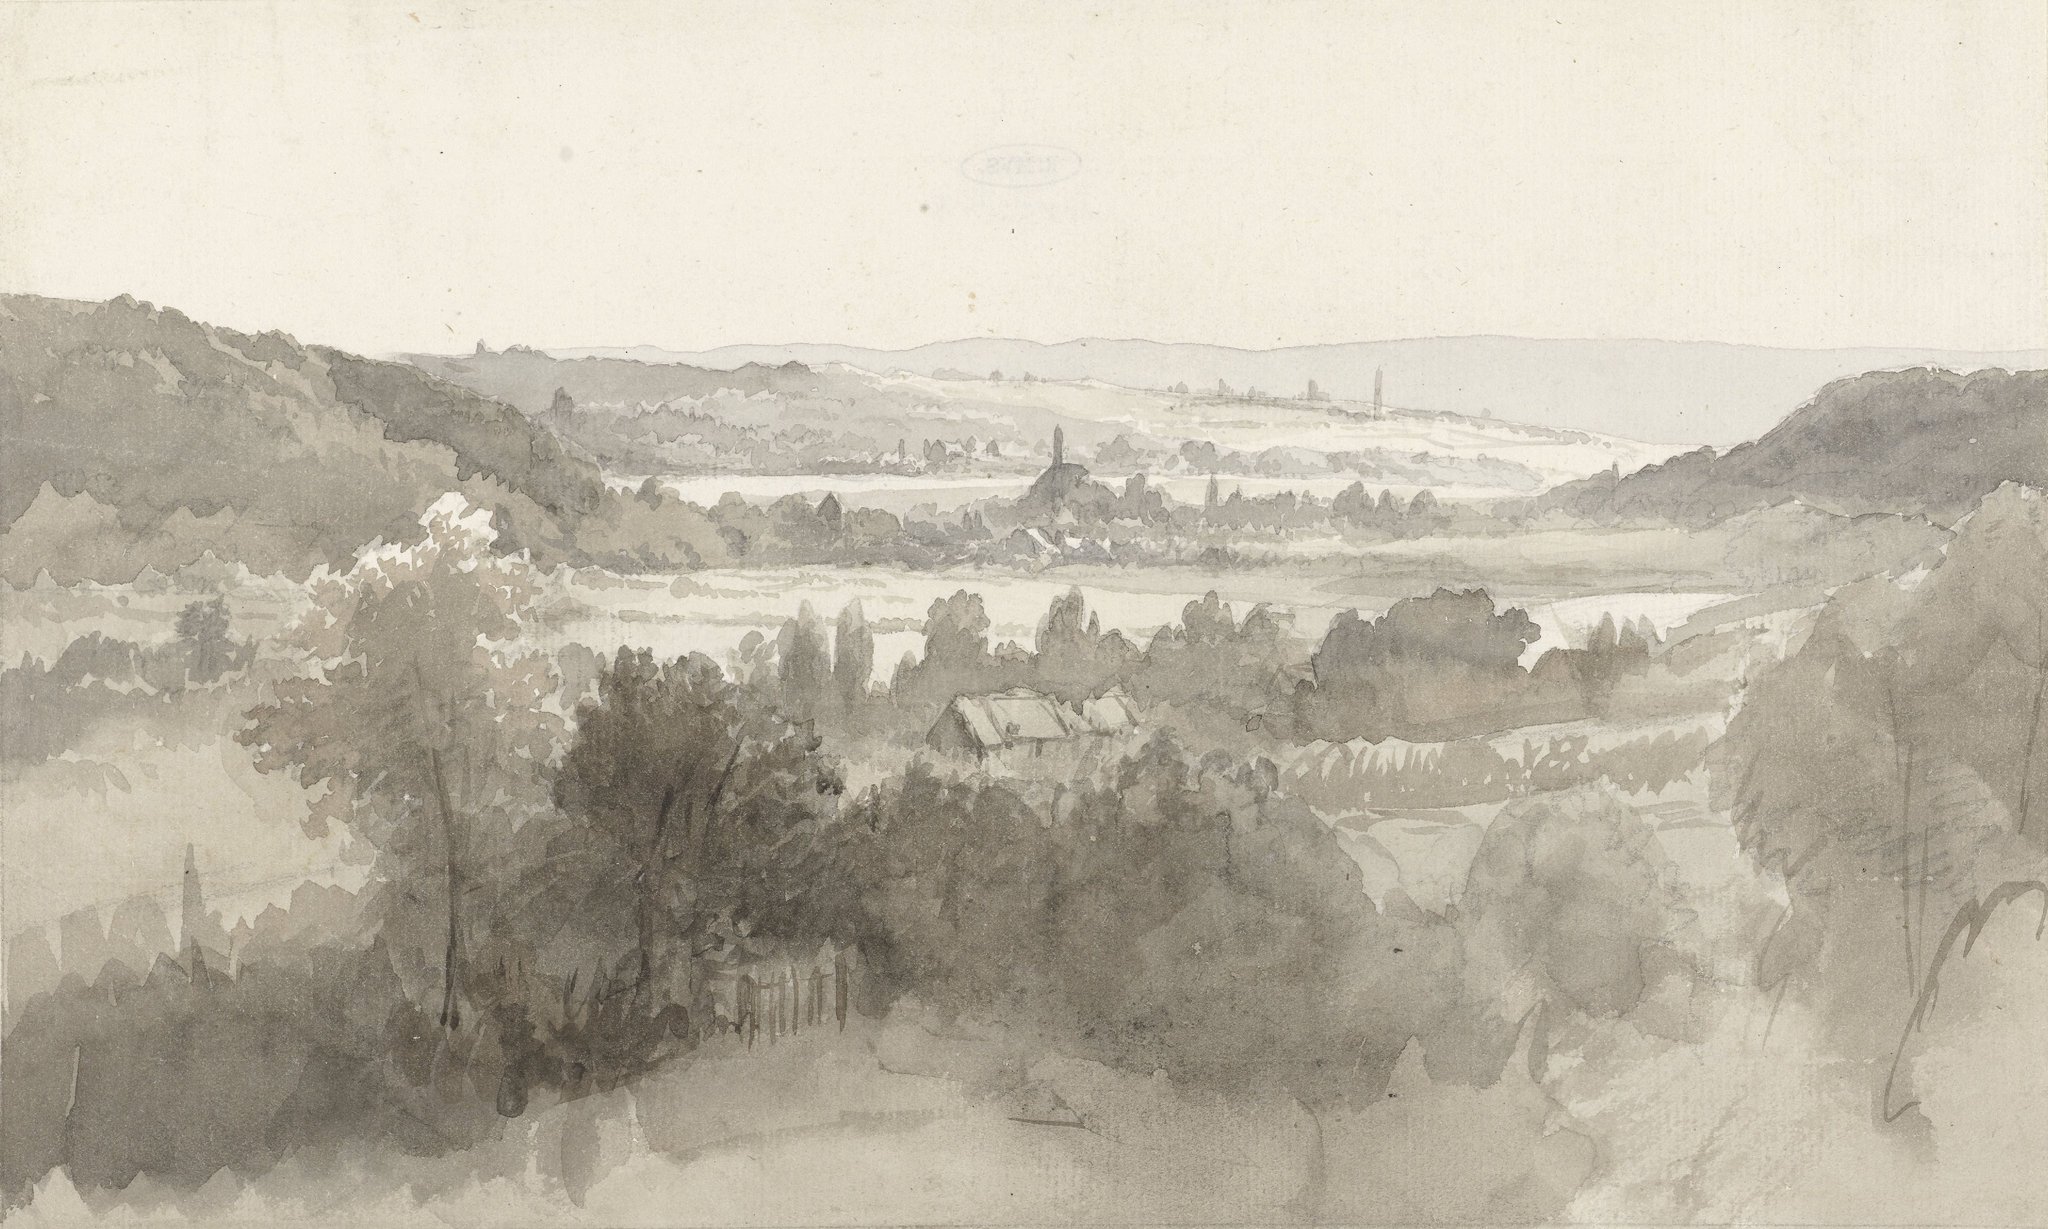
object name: watercolor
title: Gezicht op een dal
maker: willem bodeman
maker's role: draughtsman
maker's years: 1806-1880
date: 1816-1880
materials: chalk, paper, watercolor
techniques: brush